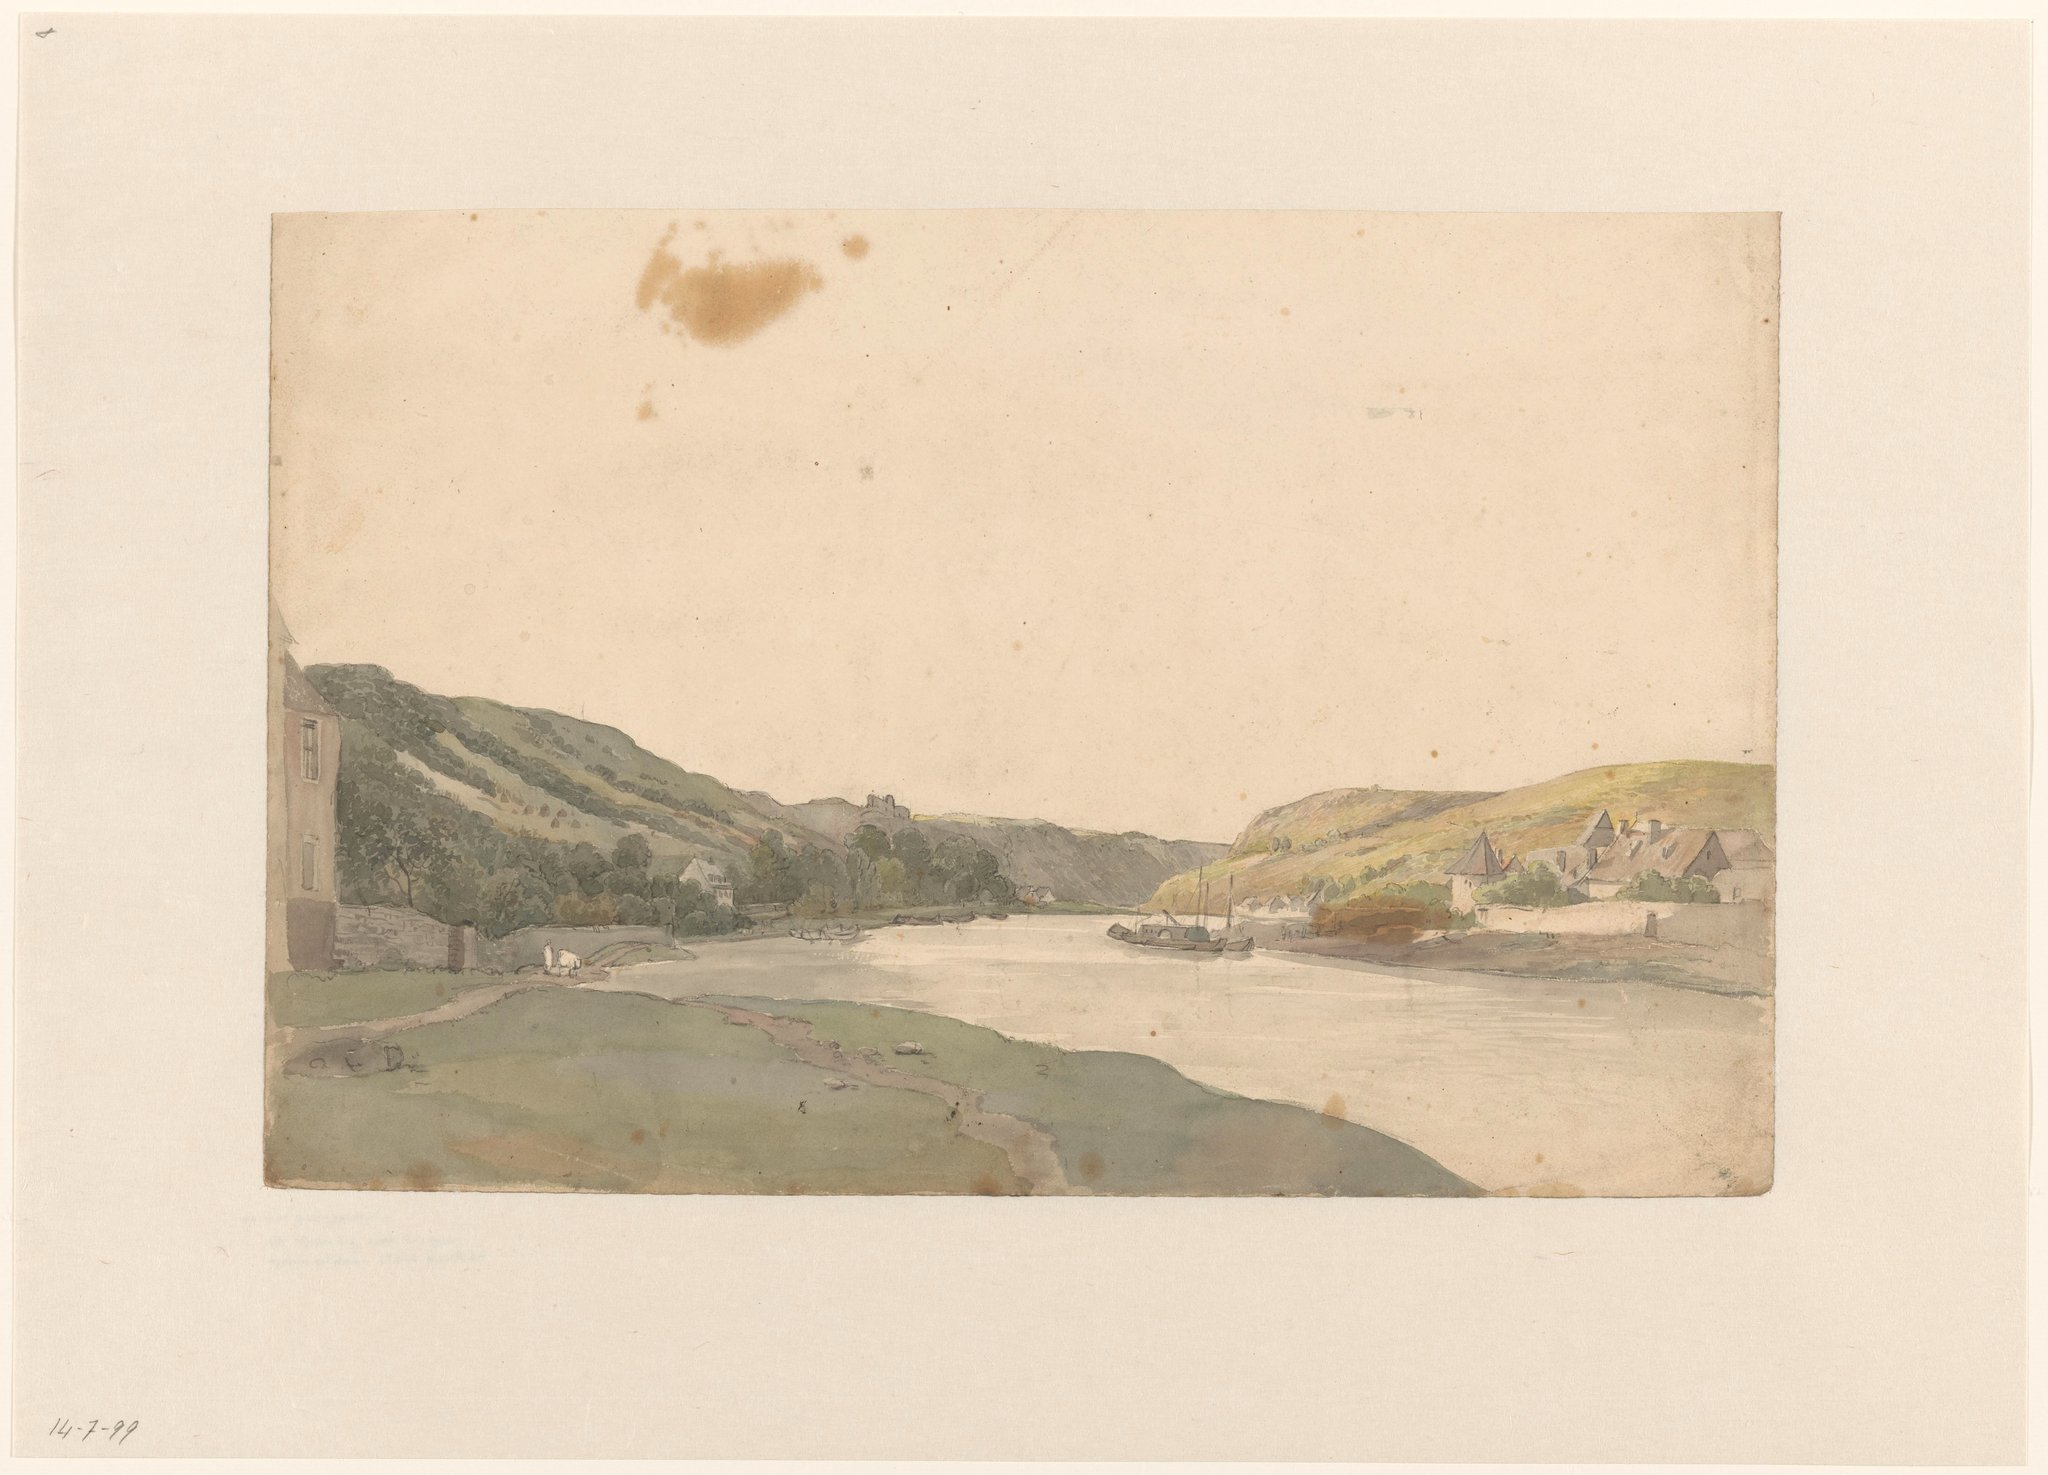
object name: drawing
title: Gezicht op de Maas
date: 1805-1860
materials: chalk, paper, watercolor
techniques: brush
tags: river